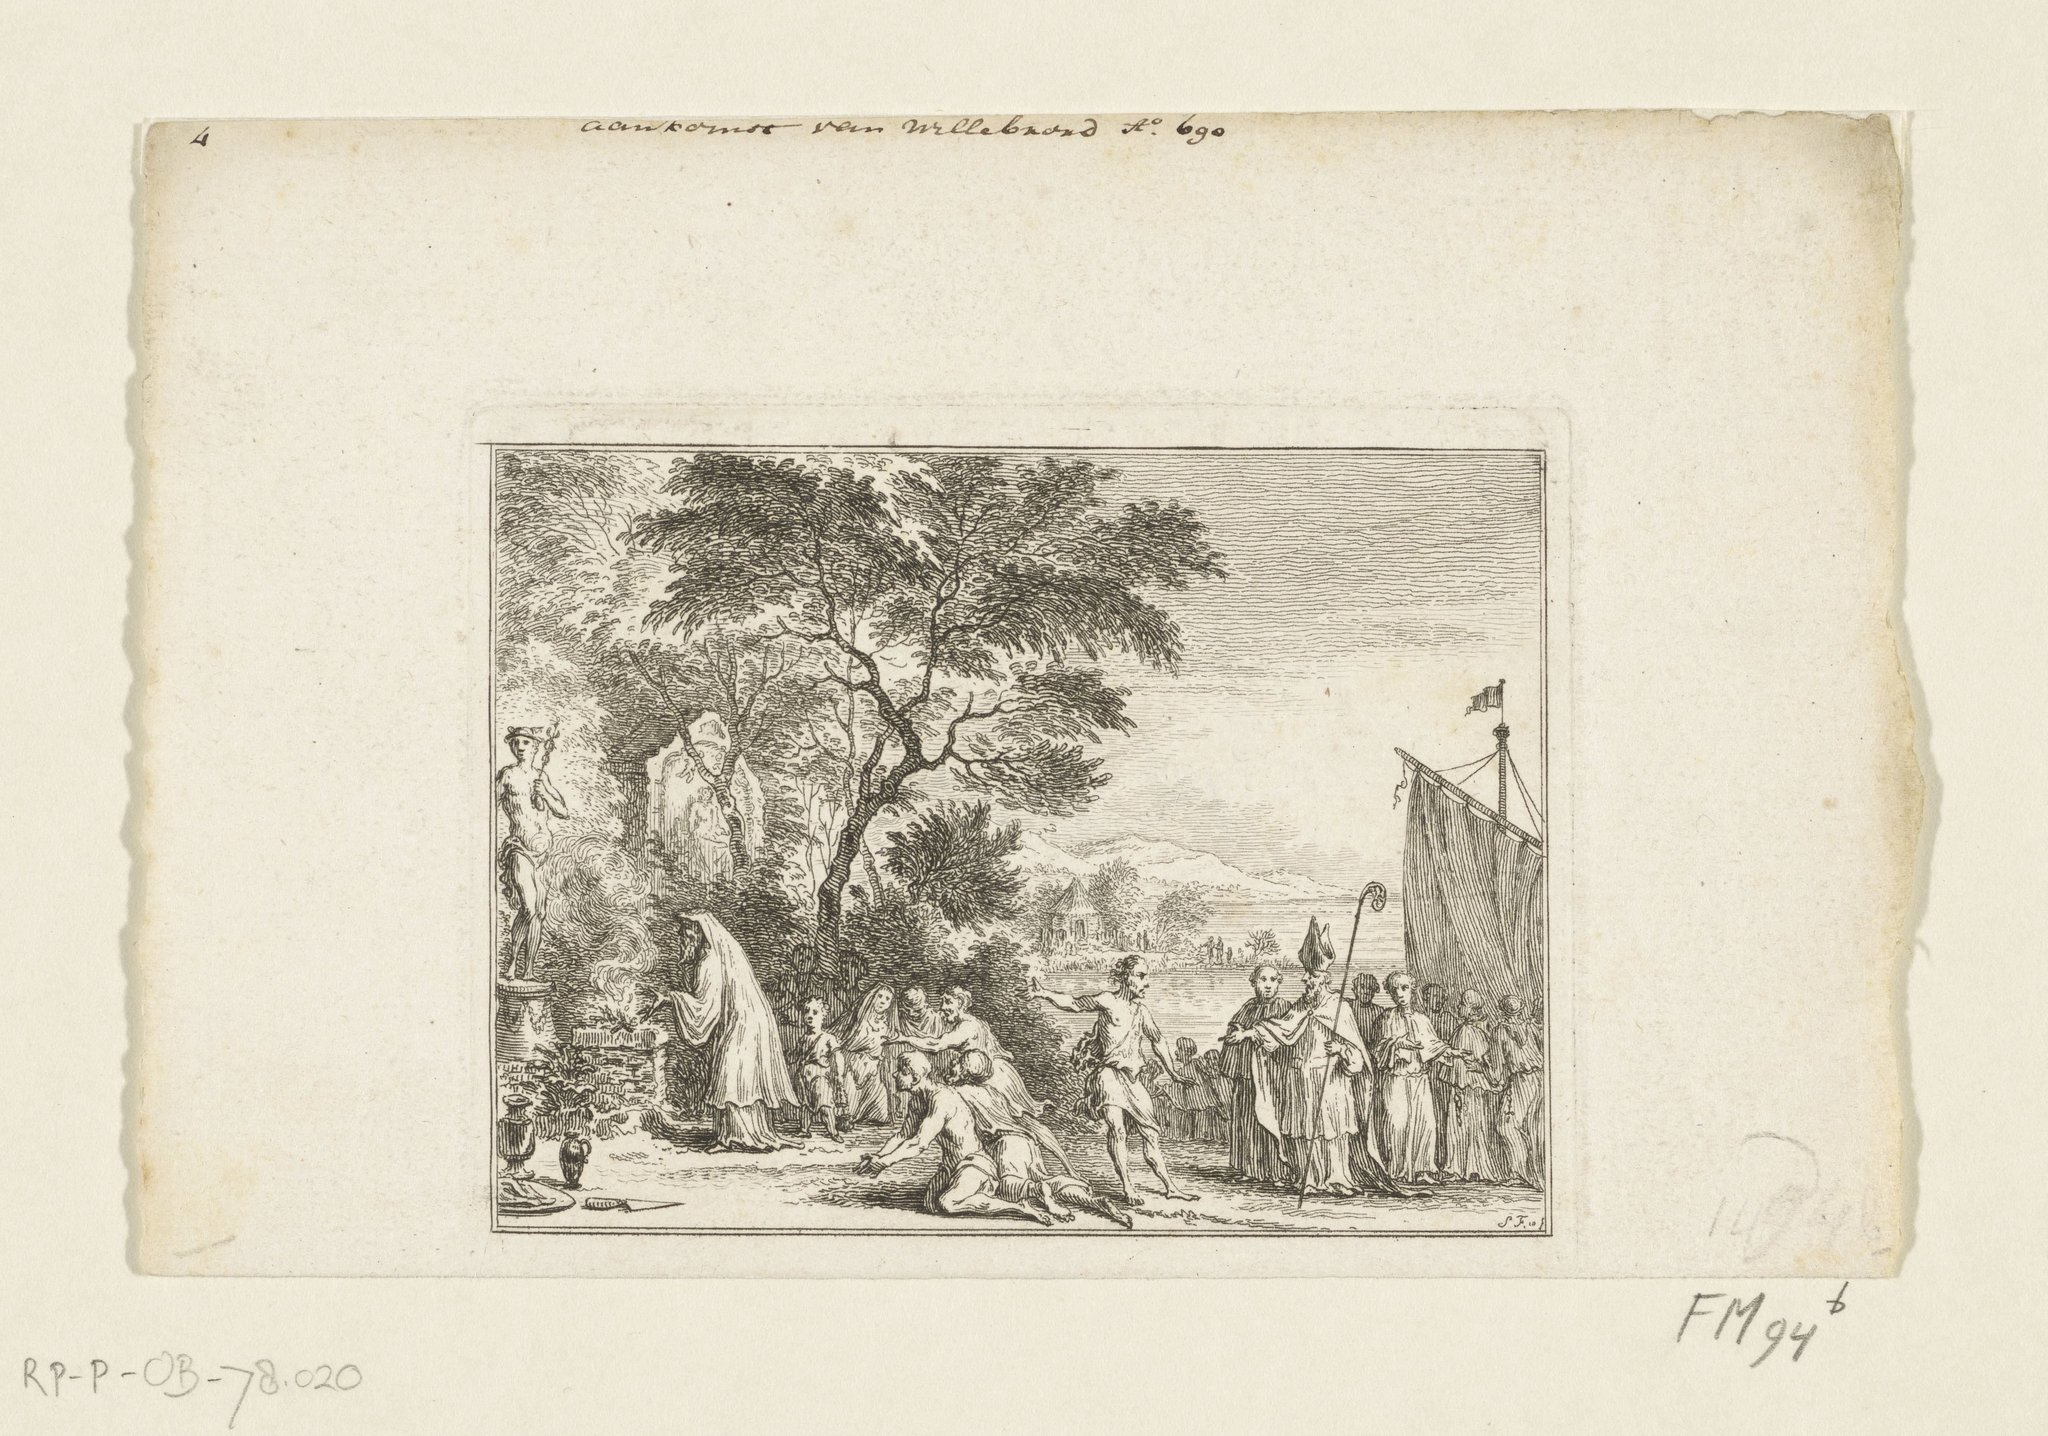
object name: history print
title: Aankomst van Willibrord, 691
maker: simon fokke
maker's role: draughtsman, print maker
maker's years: 1712-1784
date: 1722-1750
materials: paper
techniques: etching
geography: northern netherlands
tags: the 'apostle of frisia' and archbishop of utrecht, willibrord (of echternach); possible attributes: cask (barrel), well (fountain), child (on a book), model of church, stone bottles, spreading the gospel; missionary work, netherlands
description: Illustratie voor een onbekend werk, later hergebruikt in: J.W. te Water, De vaderlandsche Historie van den heere J. Wagenaar, verkort, en met leerzaame aanmerkingen, ten dienste der Nederlandsche jeugd, 1784-1800, 4 delen. Pl. VII, blz. 75. Staat vóór de letter.